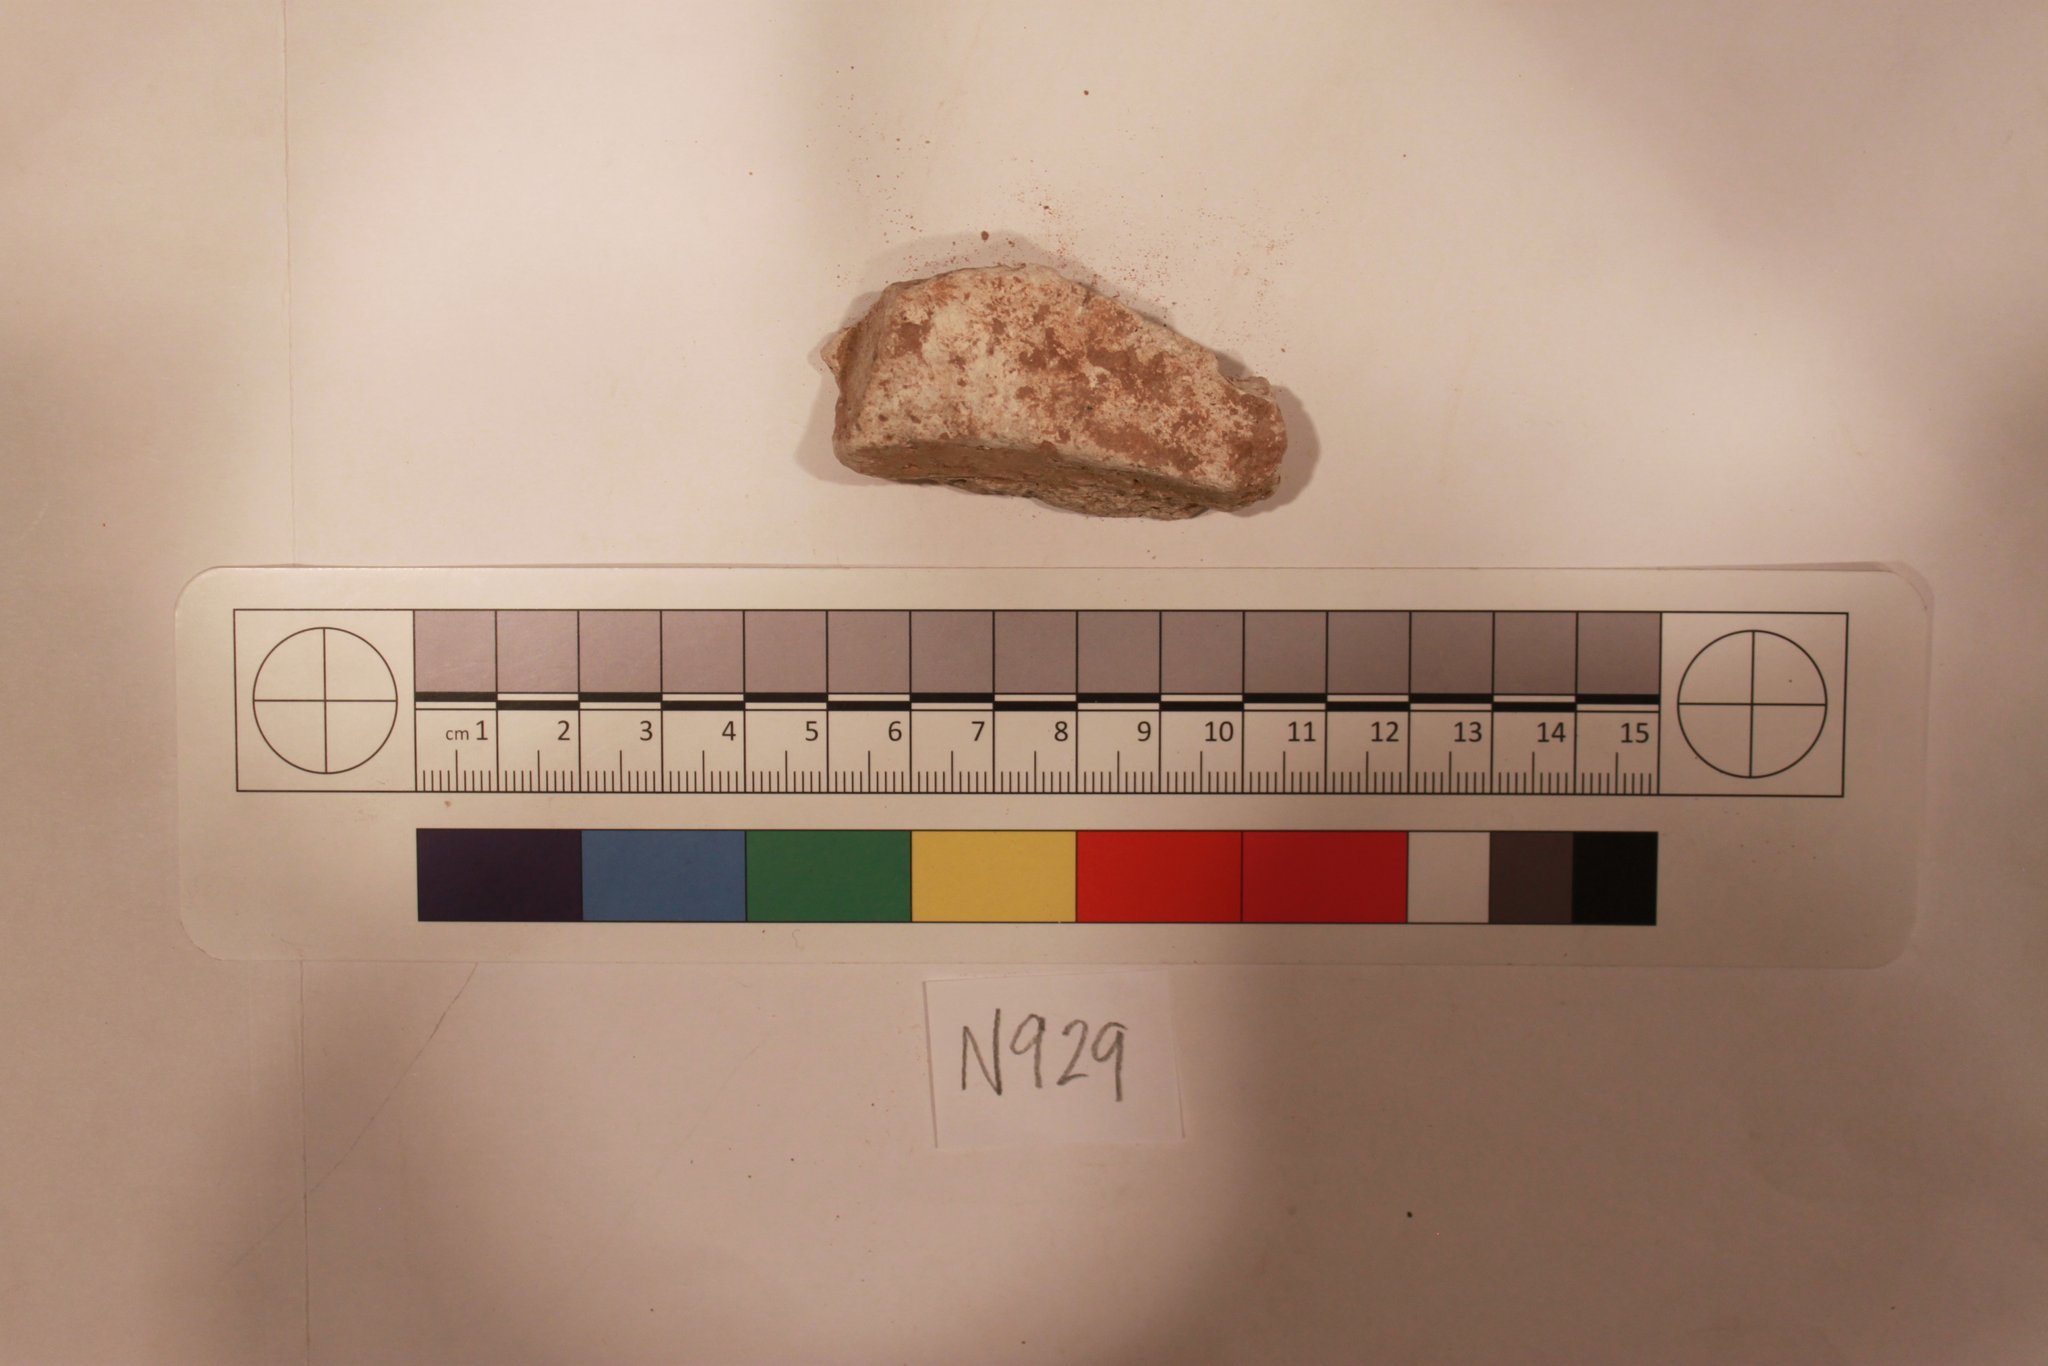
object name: fragment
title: Stucco Fragment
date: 701-1200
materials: plaster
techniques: carving, painting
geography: iran